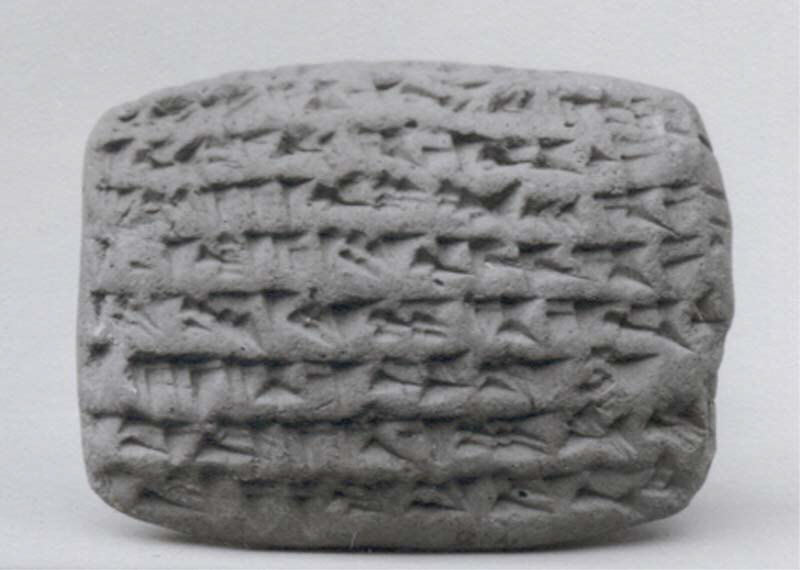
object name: cuneiform tablet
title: Cuneiform tablet: declaration before witnesses, Egibi archive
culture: achaemenid or babylonian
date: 567-468 BCE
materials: clay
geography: mesopotamia